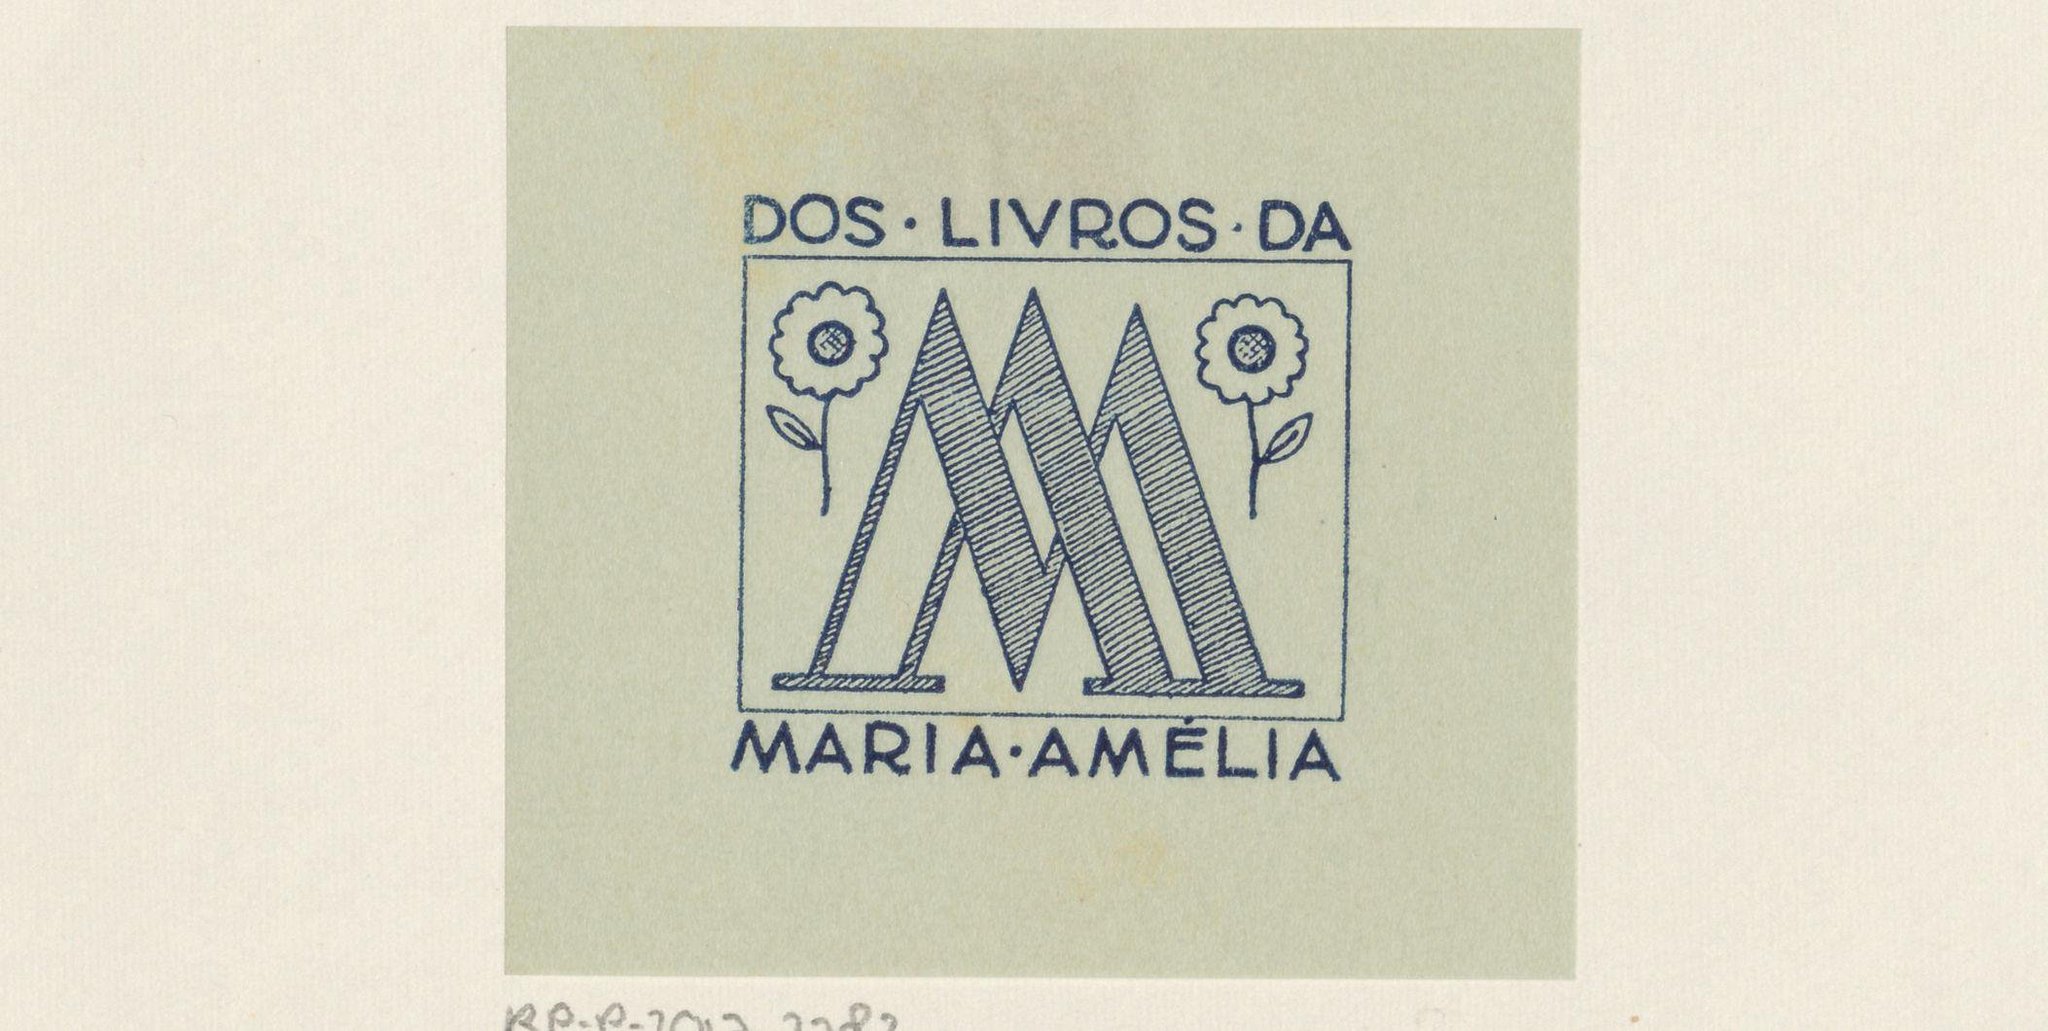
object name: bookplate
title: Ex libris van Maria Amélia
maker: Anonymous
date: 1900-1999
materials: paper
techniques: printing block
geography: portugal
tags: flowers